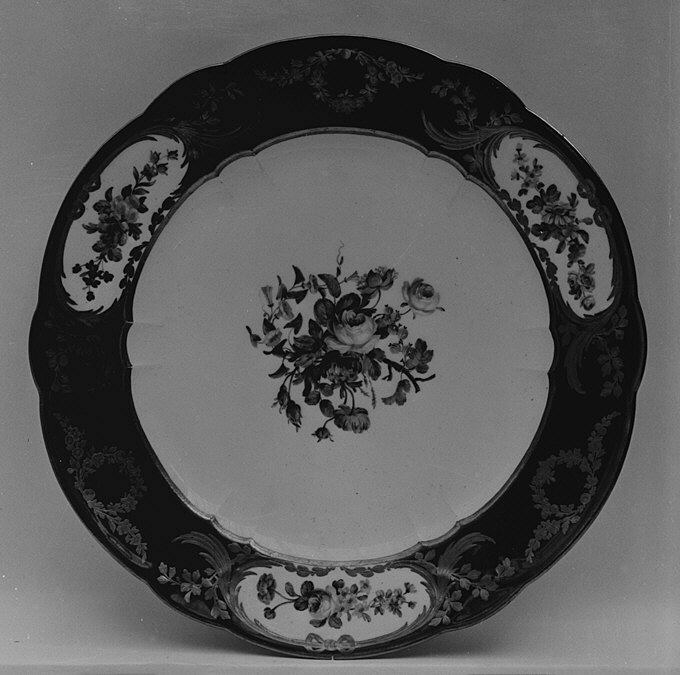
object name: plate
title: Plate (part of a service)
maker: sèvres manufactory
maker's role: manufactory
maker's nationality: french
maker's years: 1740-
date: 1784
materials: soft paste porcelain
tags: flowers